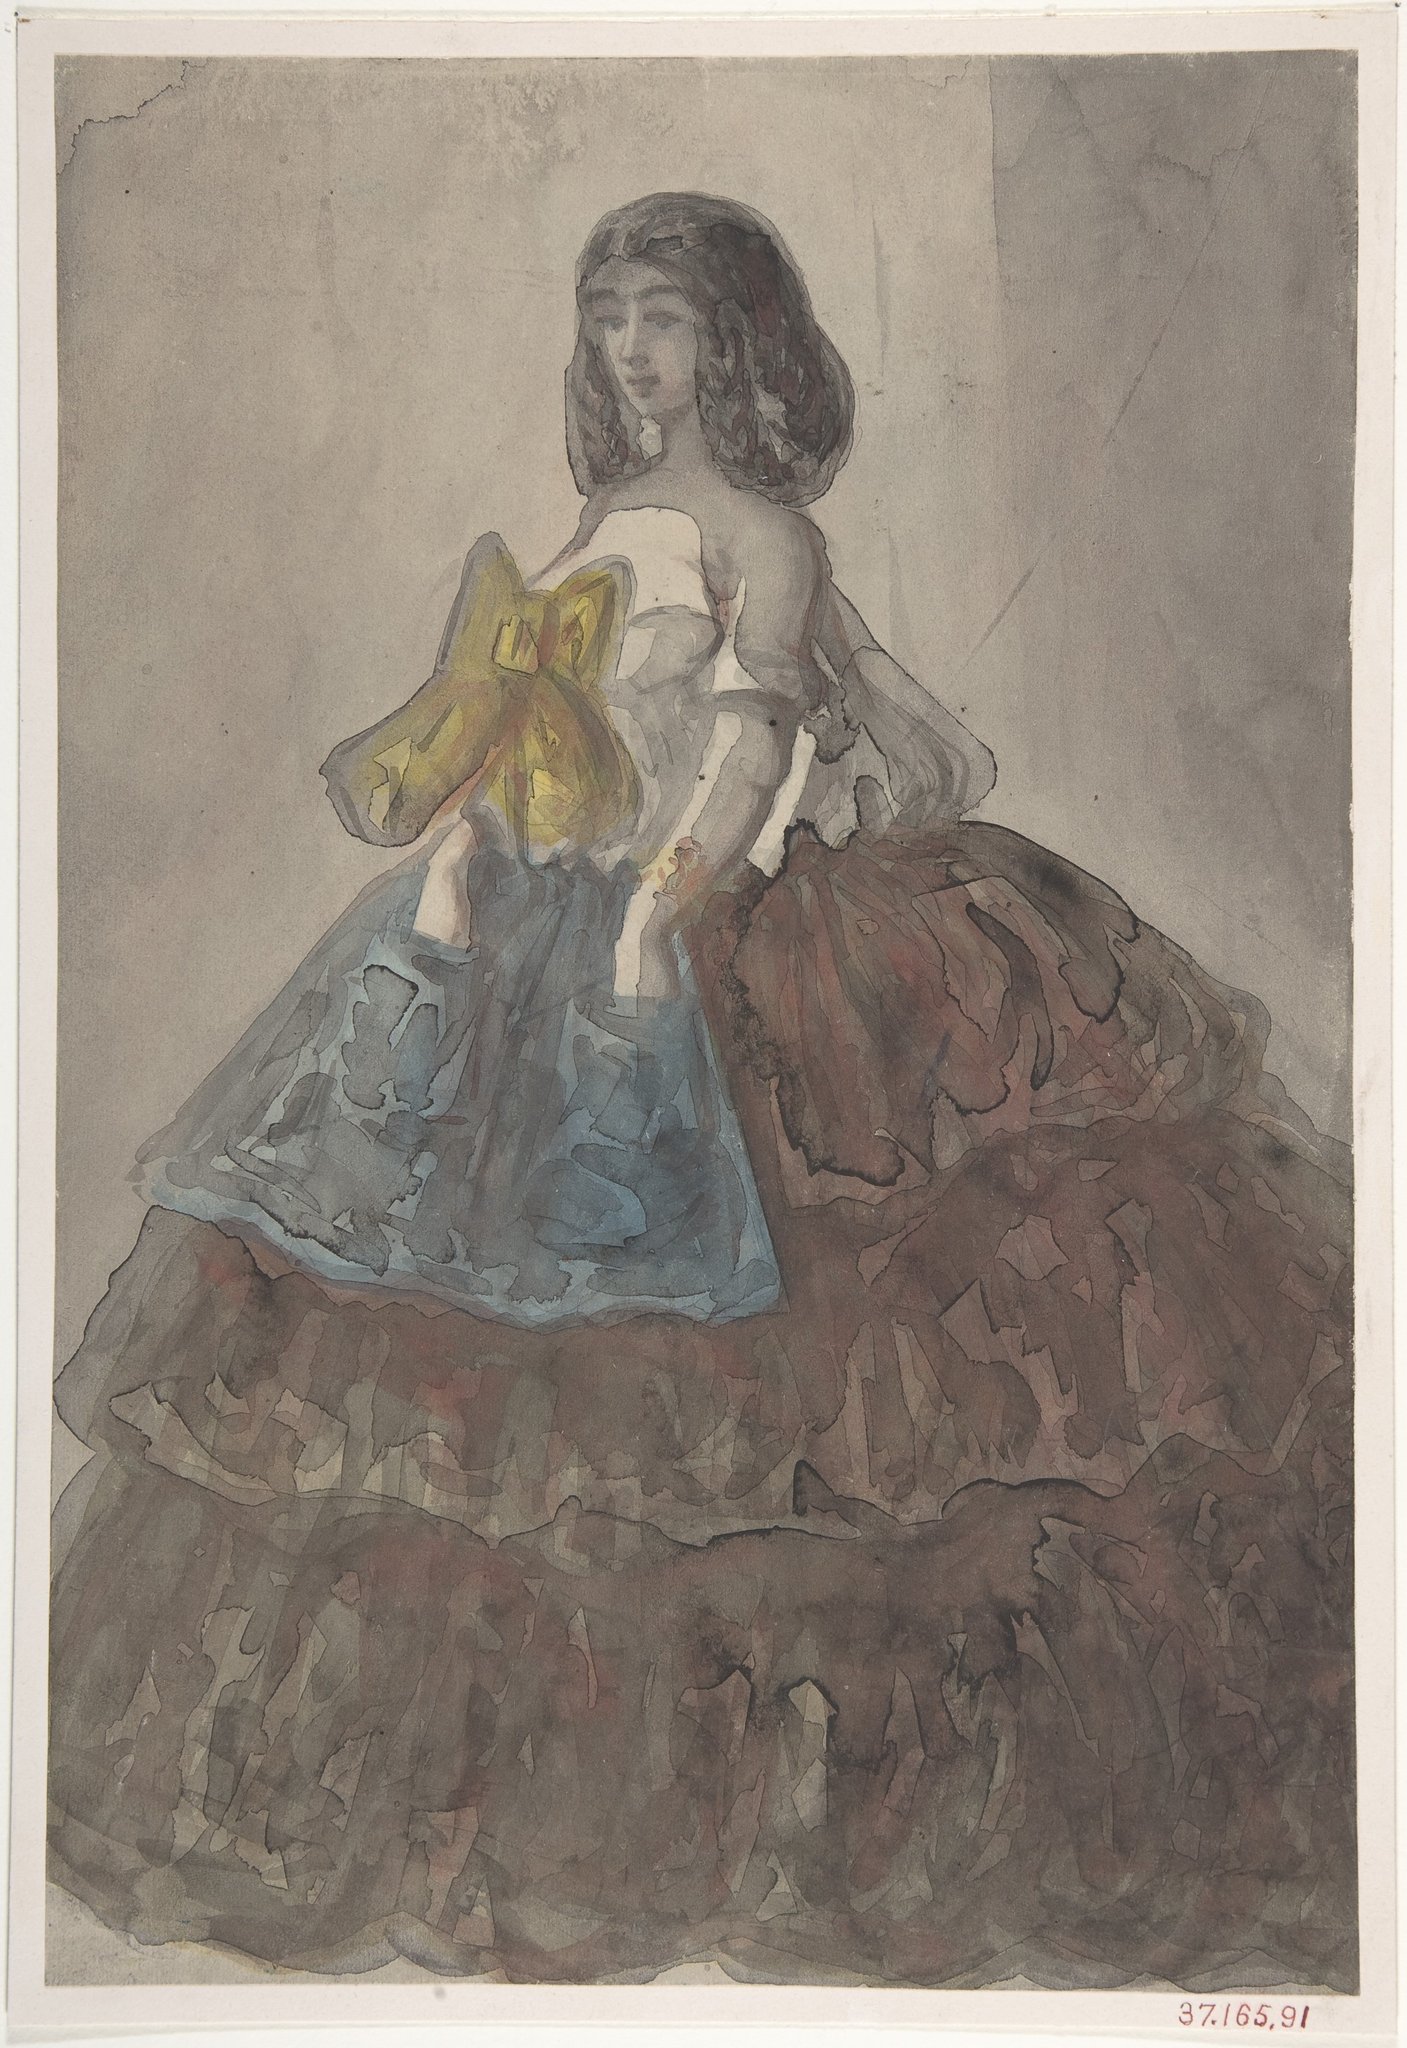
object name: drawing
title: Woman in a Tiered Gown with a Large Bow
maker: constantin guys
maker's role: artist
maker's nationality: french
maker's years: 1802-1892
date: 1801-1900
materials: graphite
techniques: brush, wash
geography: france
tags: dresses,women